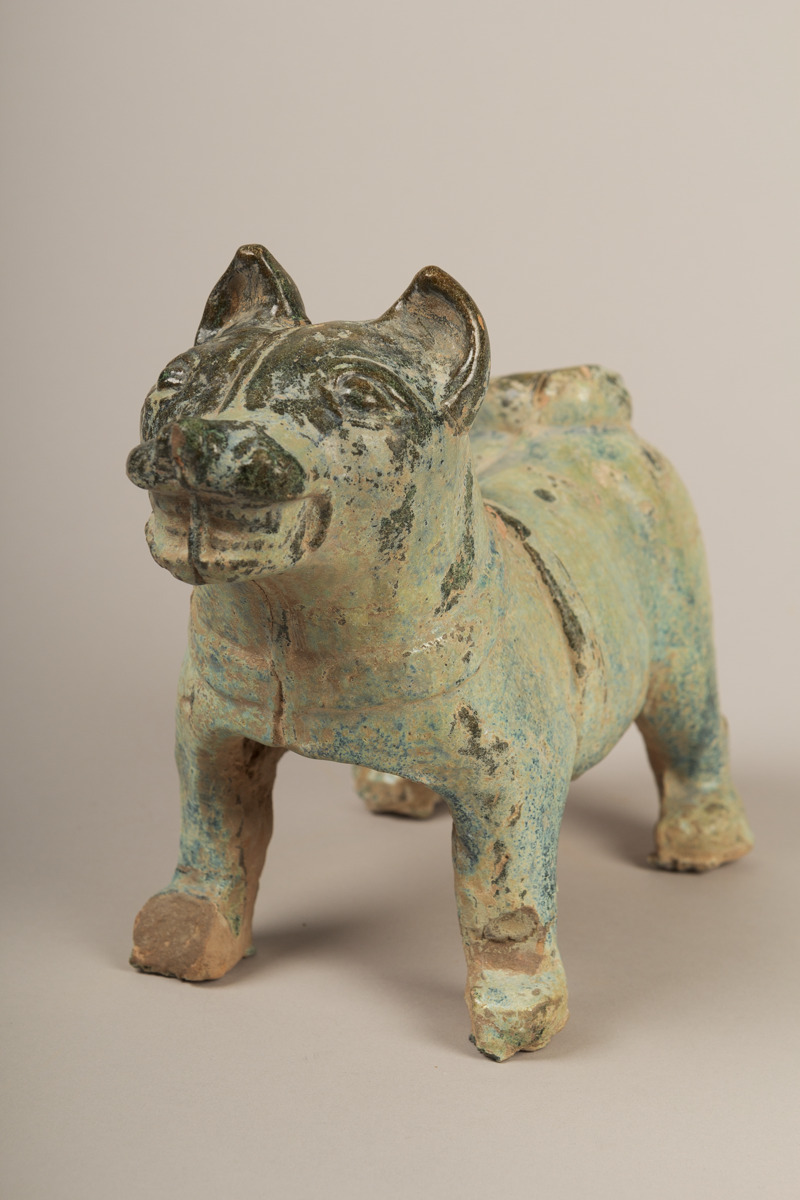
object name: figure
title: Figure of a Standing Dog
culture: chinese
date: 1-200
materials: earthenware, glaze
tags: dogs